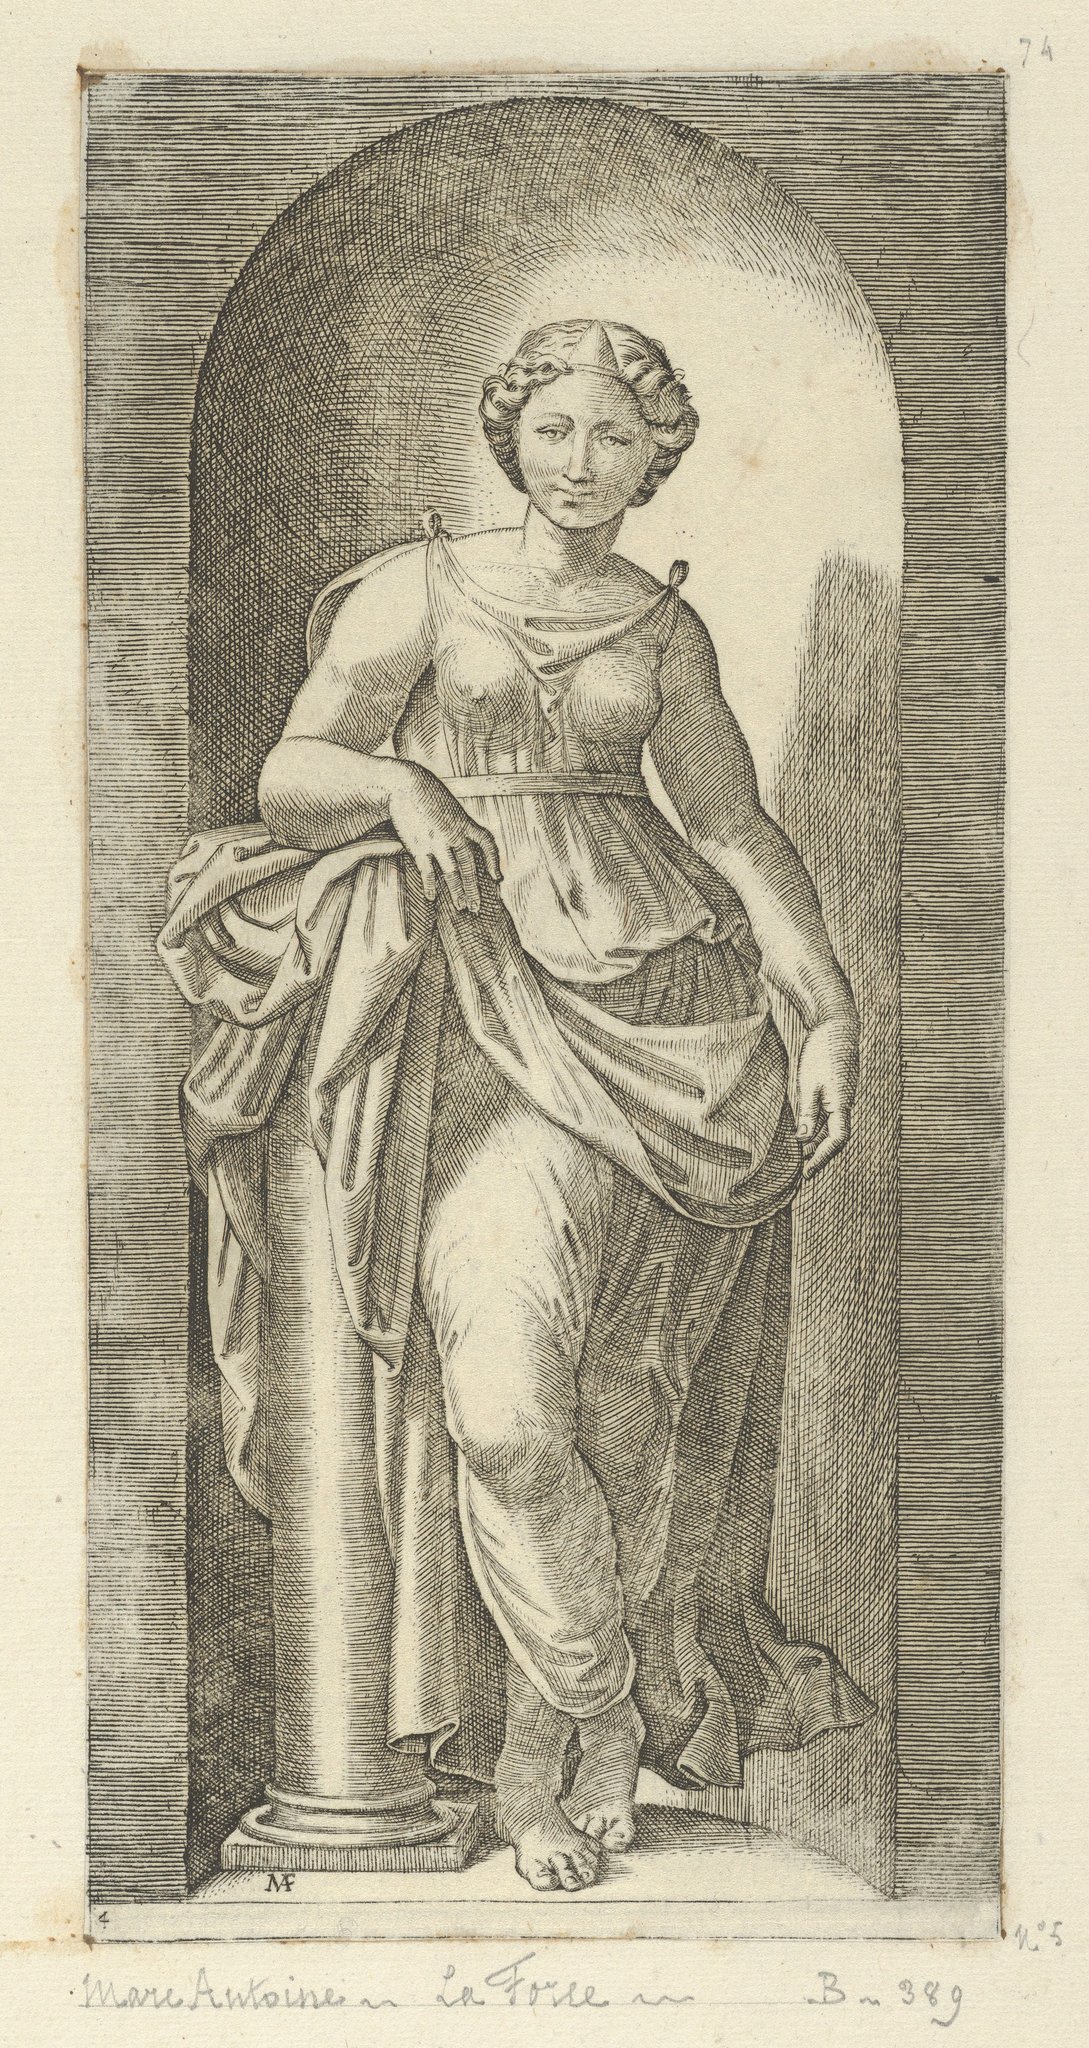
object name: print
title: Fortitude or Strength personified by a woman standing in a nice resting her arm on a column, from "The Virtues"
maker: marcantonio raimondi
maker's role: artist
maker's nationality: italian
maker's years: 1475-1534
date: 1515-1525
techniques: engraving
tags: women